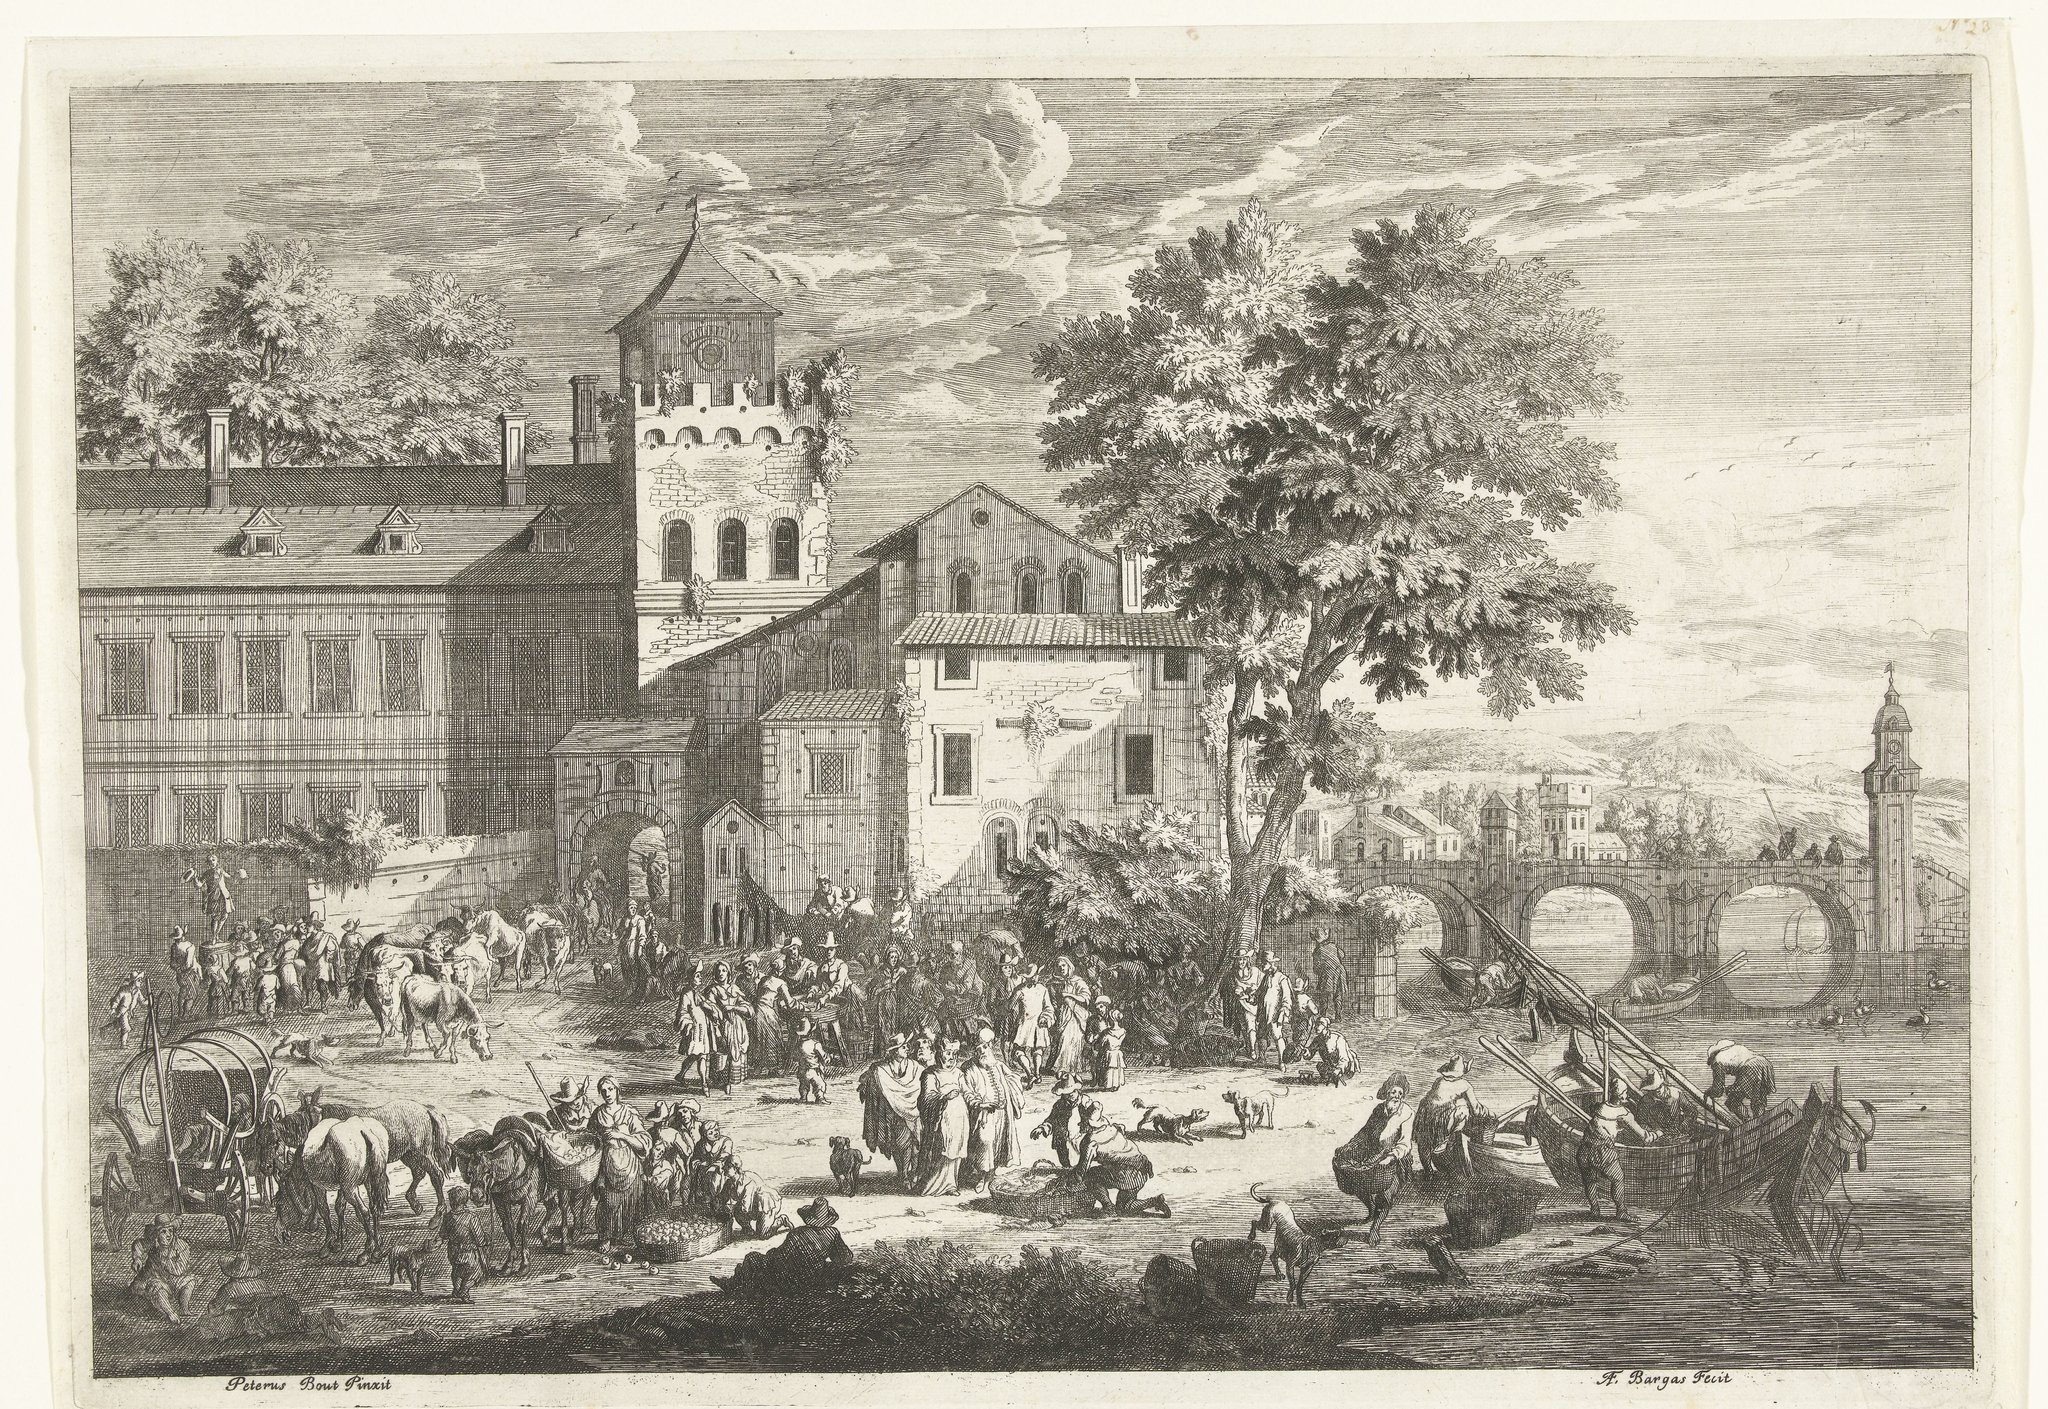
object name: print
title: Stadsgezicht met markt voor stadspoort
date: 1660-1699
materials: paper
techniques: etching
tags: market, city-gate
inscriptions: collector's mark: Lugt 240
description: Stadsgezicht met stad aan rivier waar marktkooplieden hun waren verkopen bij een stadspoort. Op de markt wordt onder andere fruit en vis verkocht en staat een stadsomroeper op een ton voor een groep toehoorders. Op de rivieroever worden vissersboten uitgeladen.